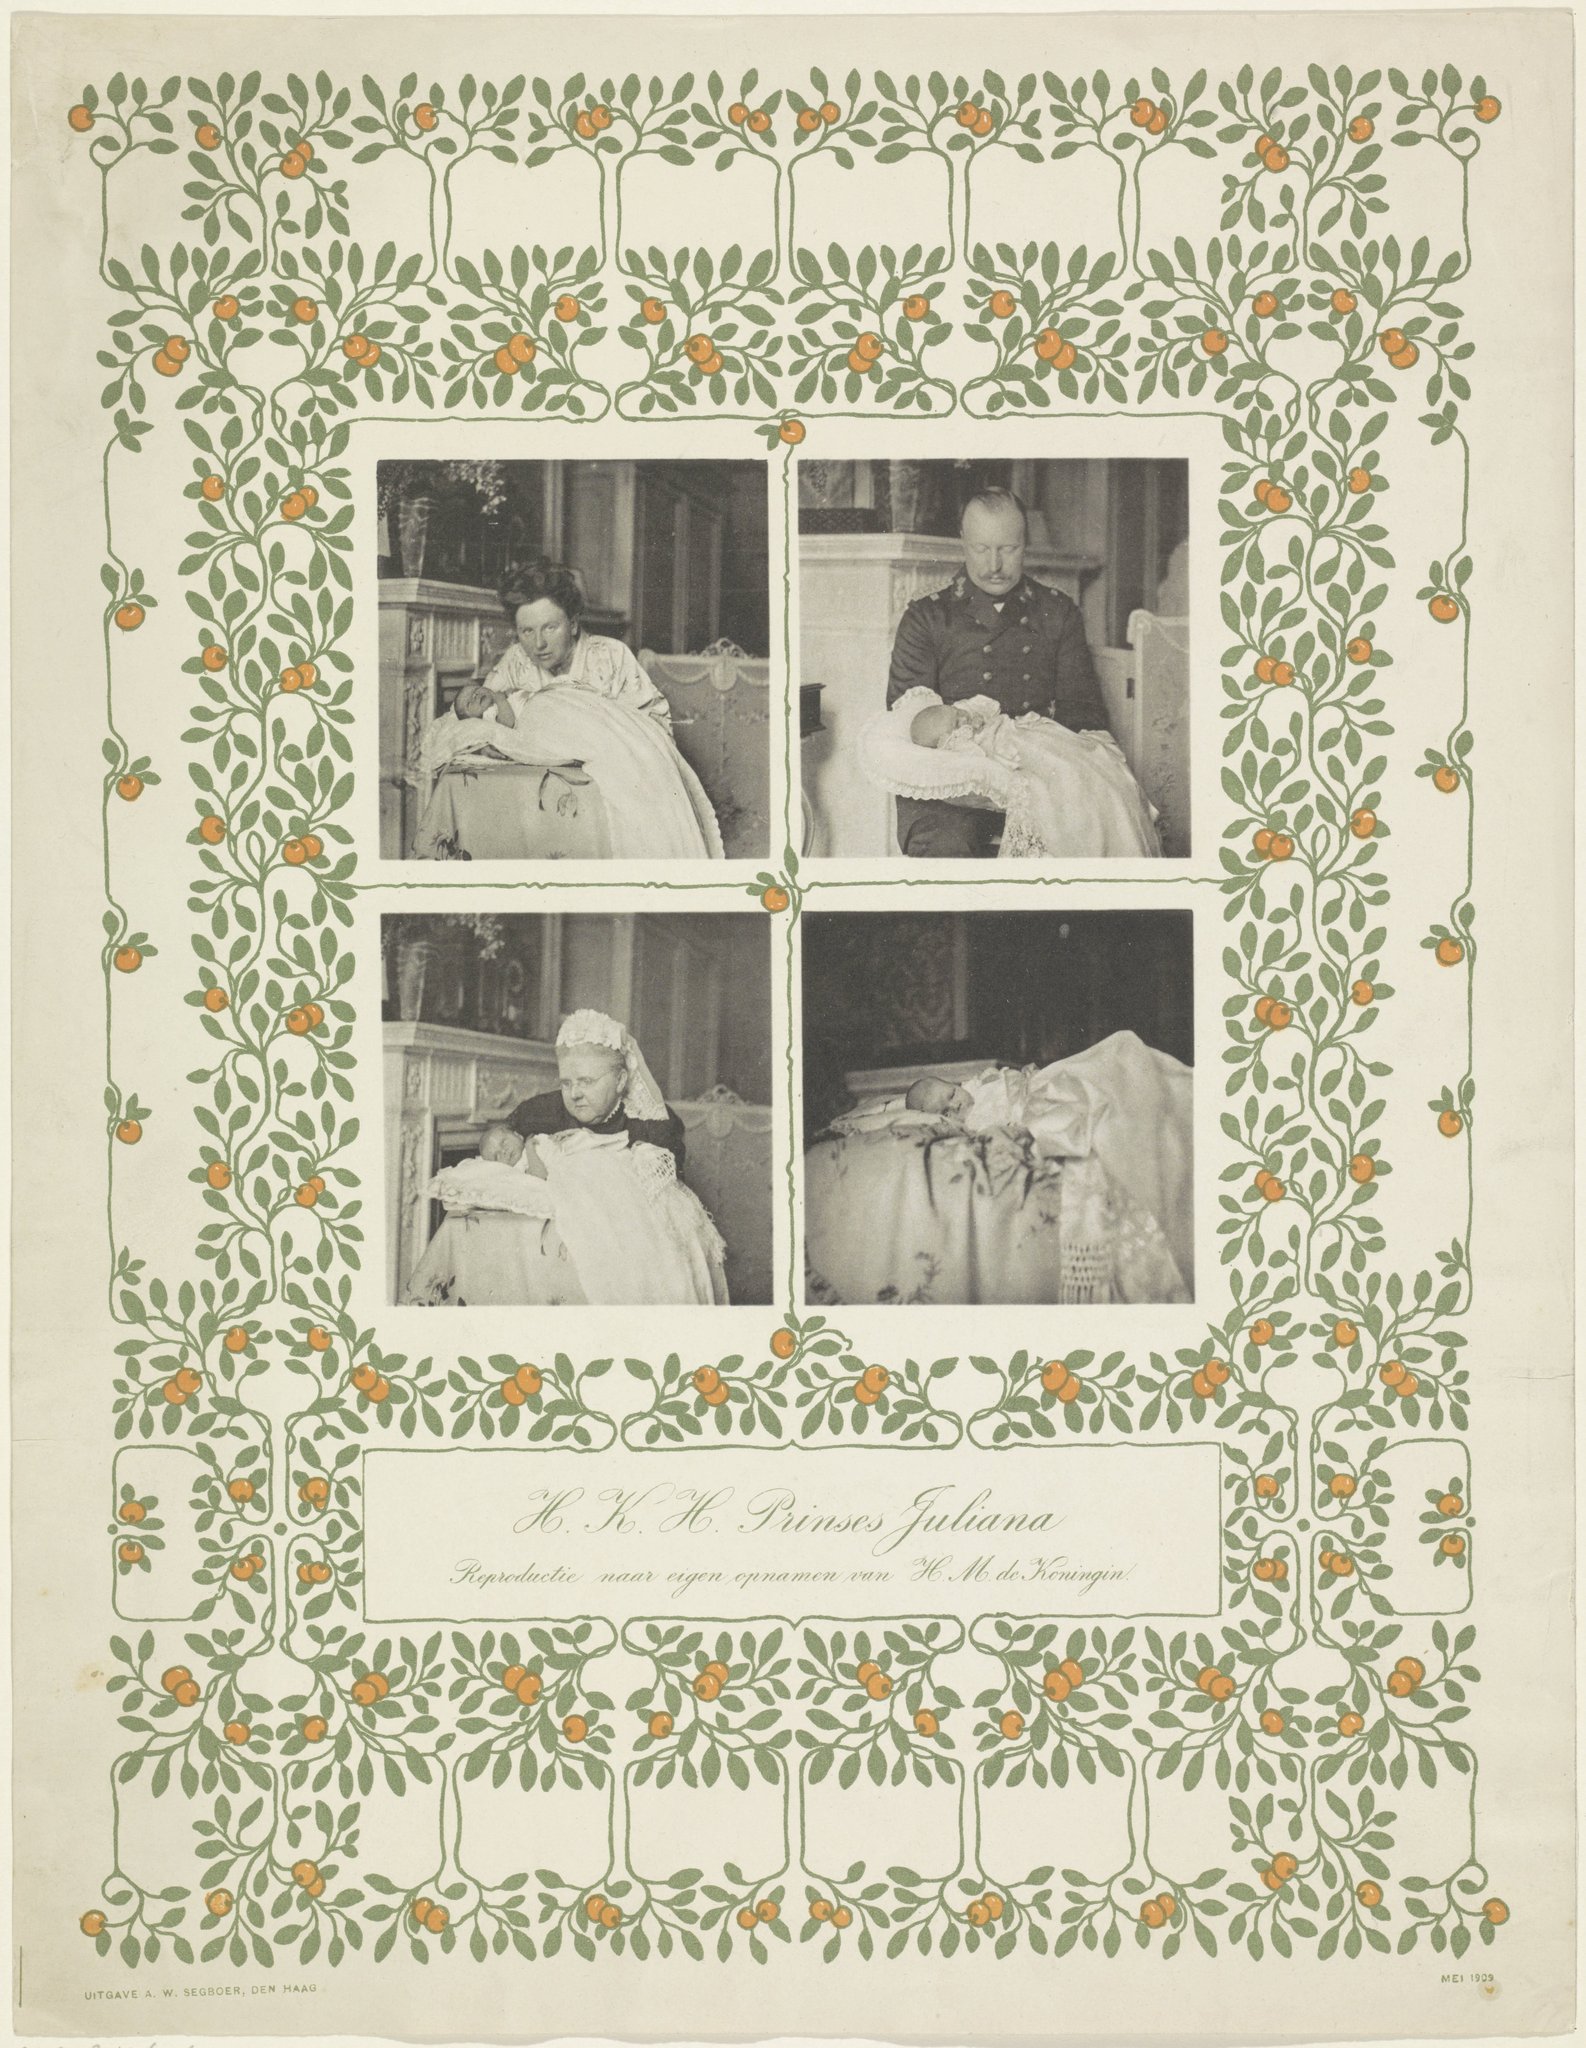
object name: photomechanical print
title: Portretten van Emma, koningin-regentes der Nederlanden, Wilhelmina, koningin der Nederlanden, Hendrik van Mecklenburg-Schwerin en Juliana, koningin der Nederlanden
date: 1905-1909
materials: paper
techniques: photograph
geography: netherlands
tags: print maker, wilhelmina of the netherlands, hendrik (prins der nederlanden (1876-1934)), the hague, emma (queen consort of the netherlands), juliana of the netherlands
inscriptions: date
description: De hier vermelde titel verwijst naar de hoogst verkregen titel van de geportretteerde, niet per se naar de titel die de geportretteerde op deze voorstelling draagt.